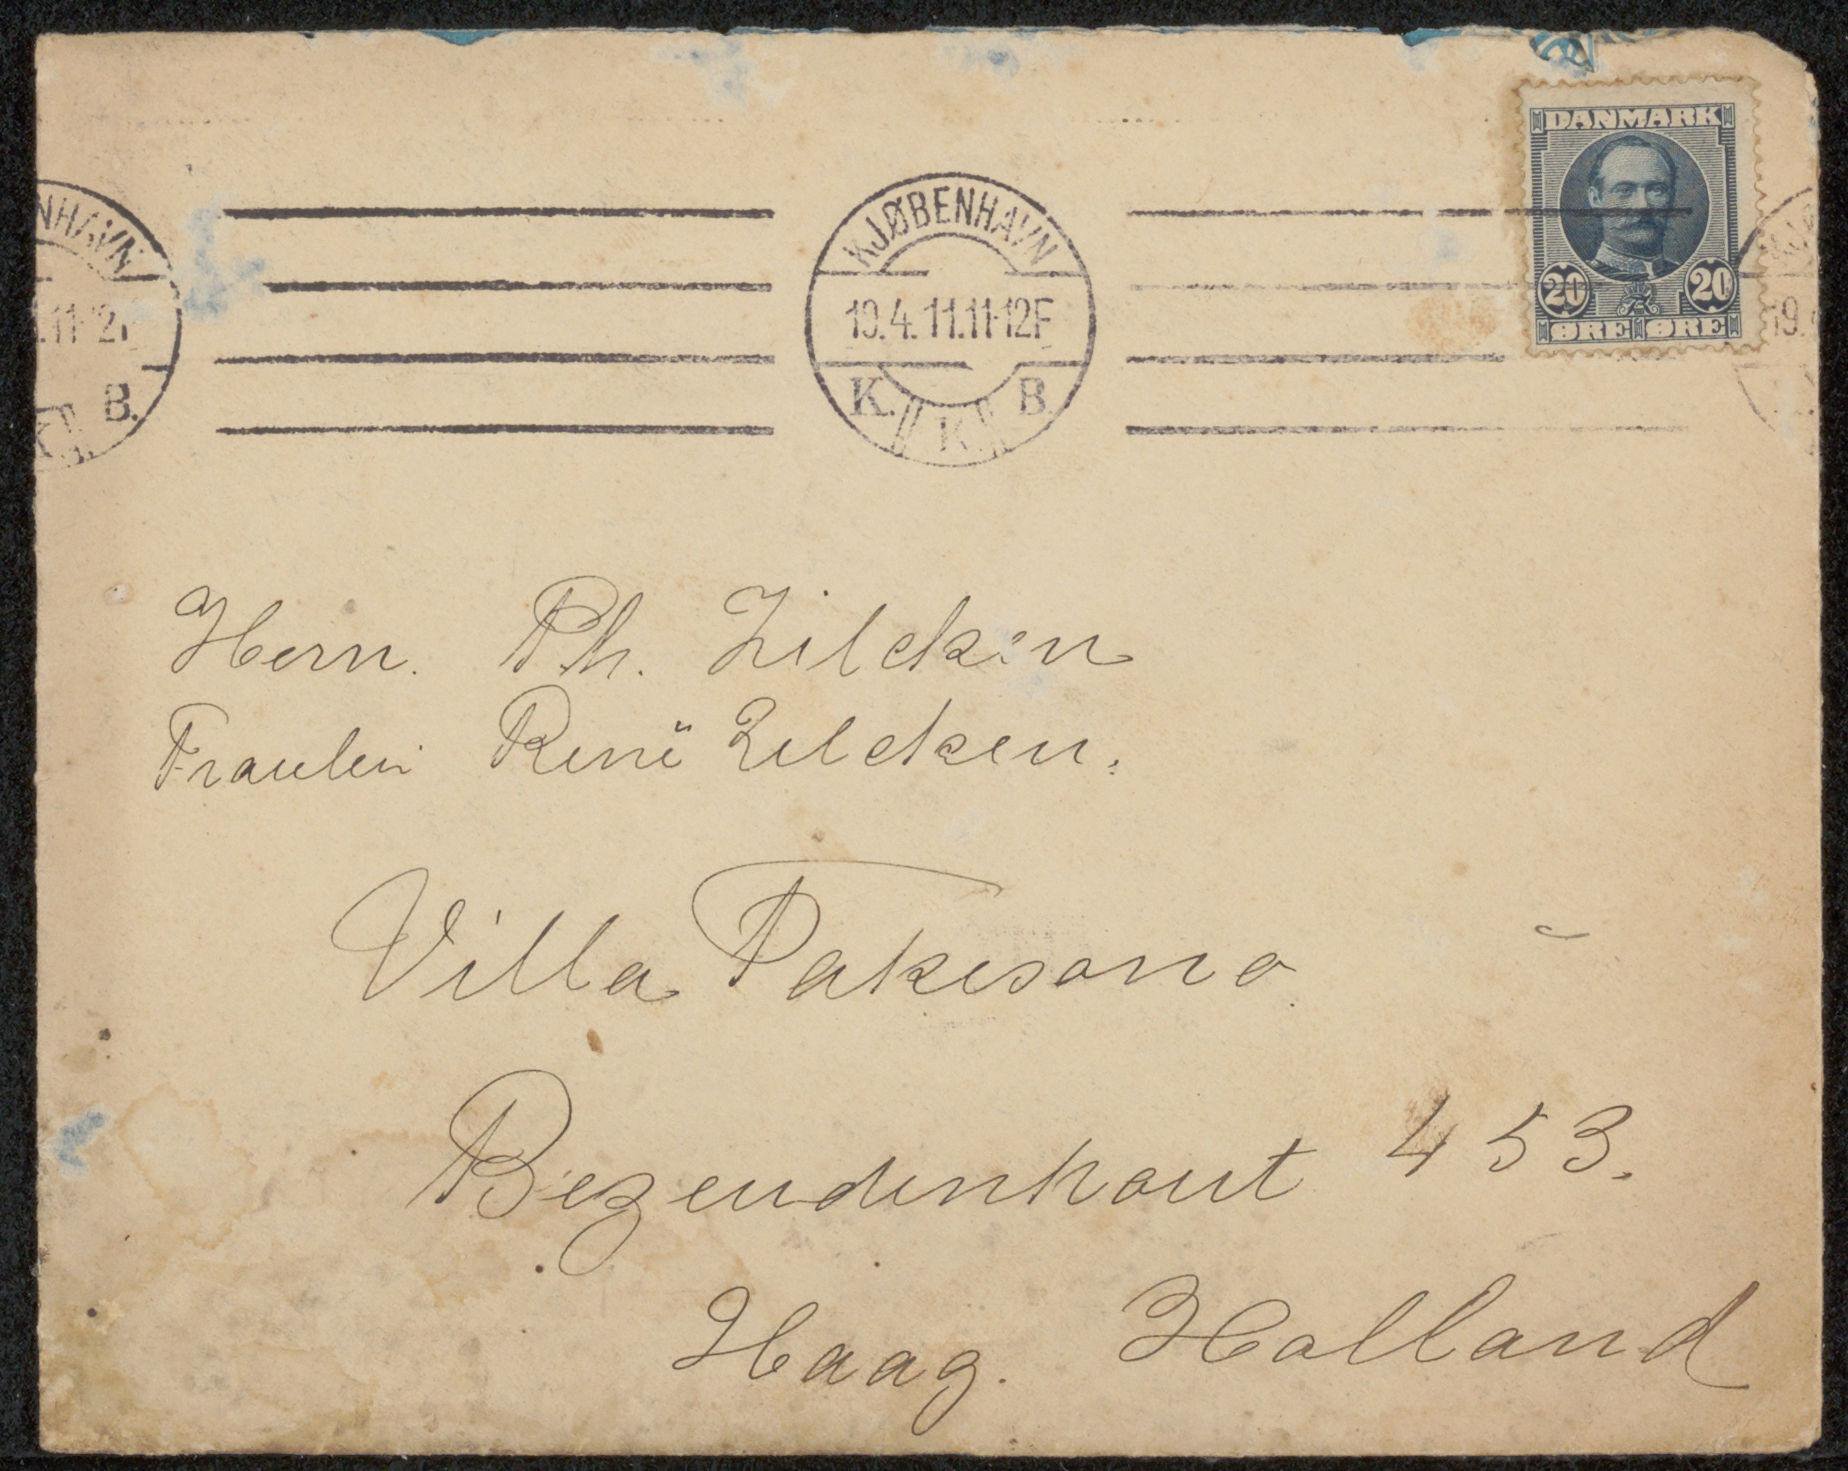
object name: envelope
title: Envelop aan Philip Zilcken en Renée Hélène Laure Zilcken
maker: dagmar frandsen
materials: ink, paper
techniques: pen, writing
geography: copenhagen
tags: voorburg, print maker, renée hélène laure zilcken, the hague, painter, draughtsman, philip zilcken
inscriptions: collector's mark: ‘RPK’